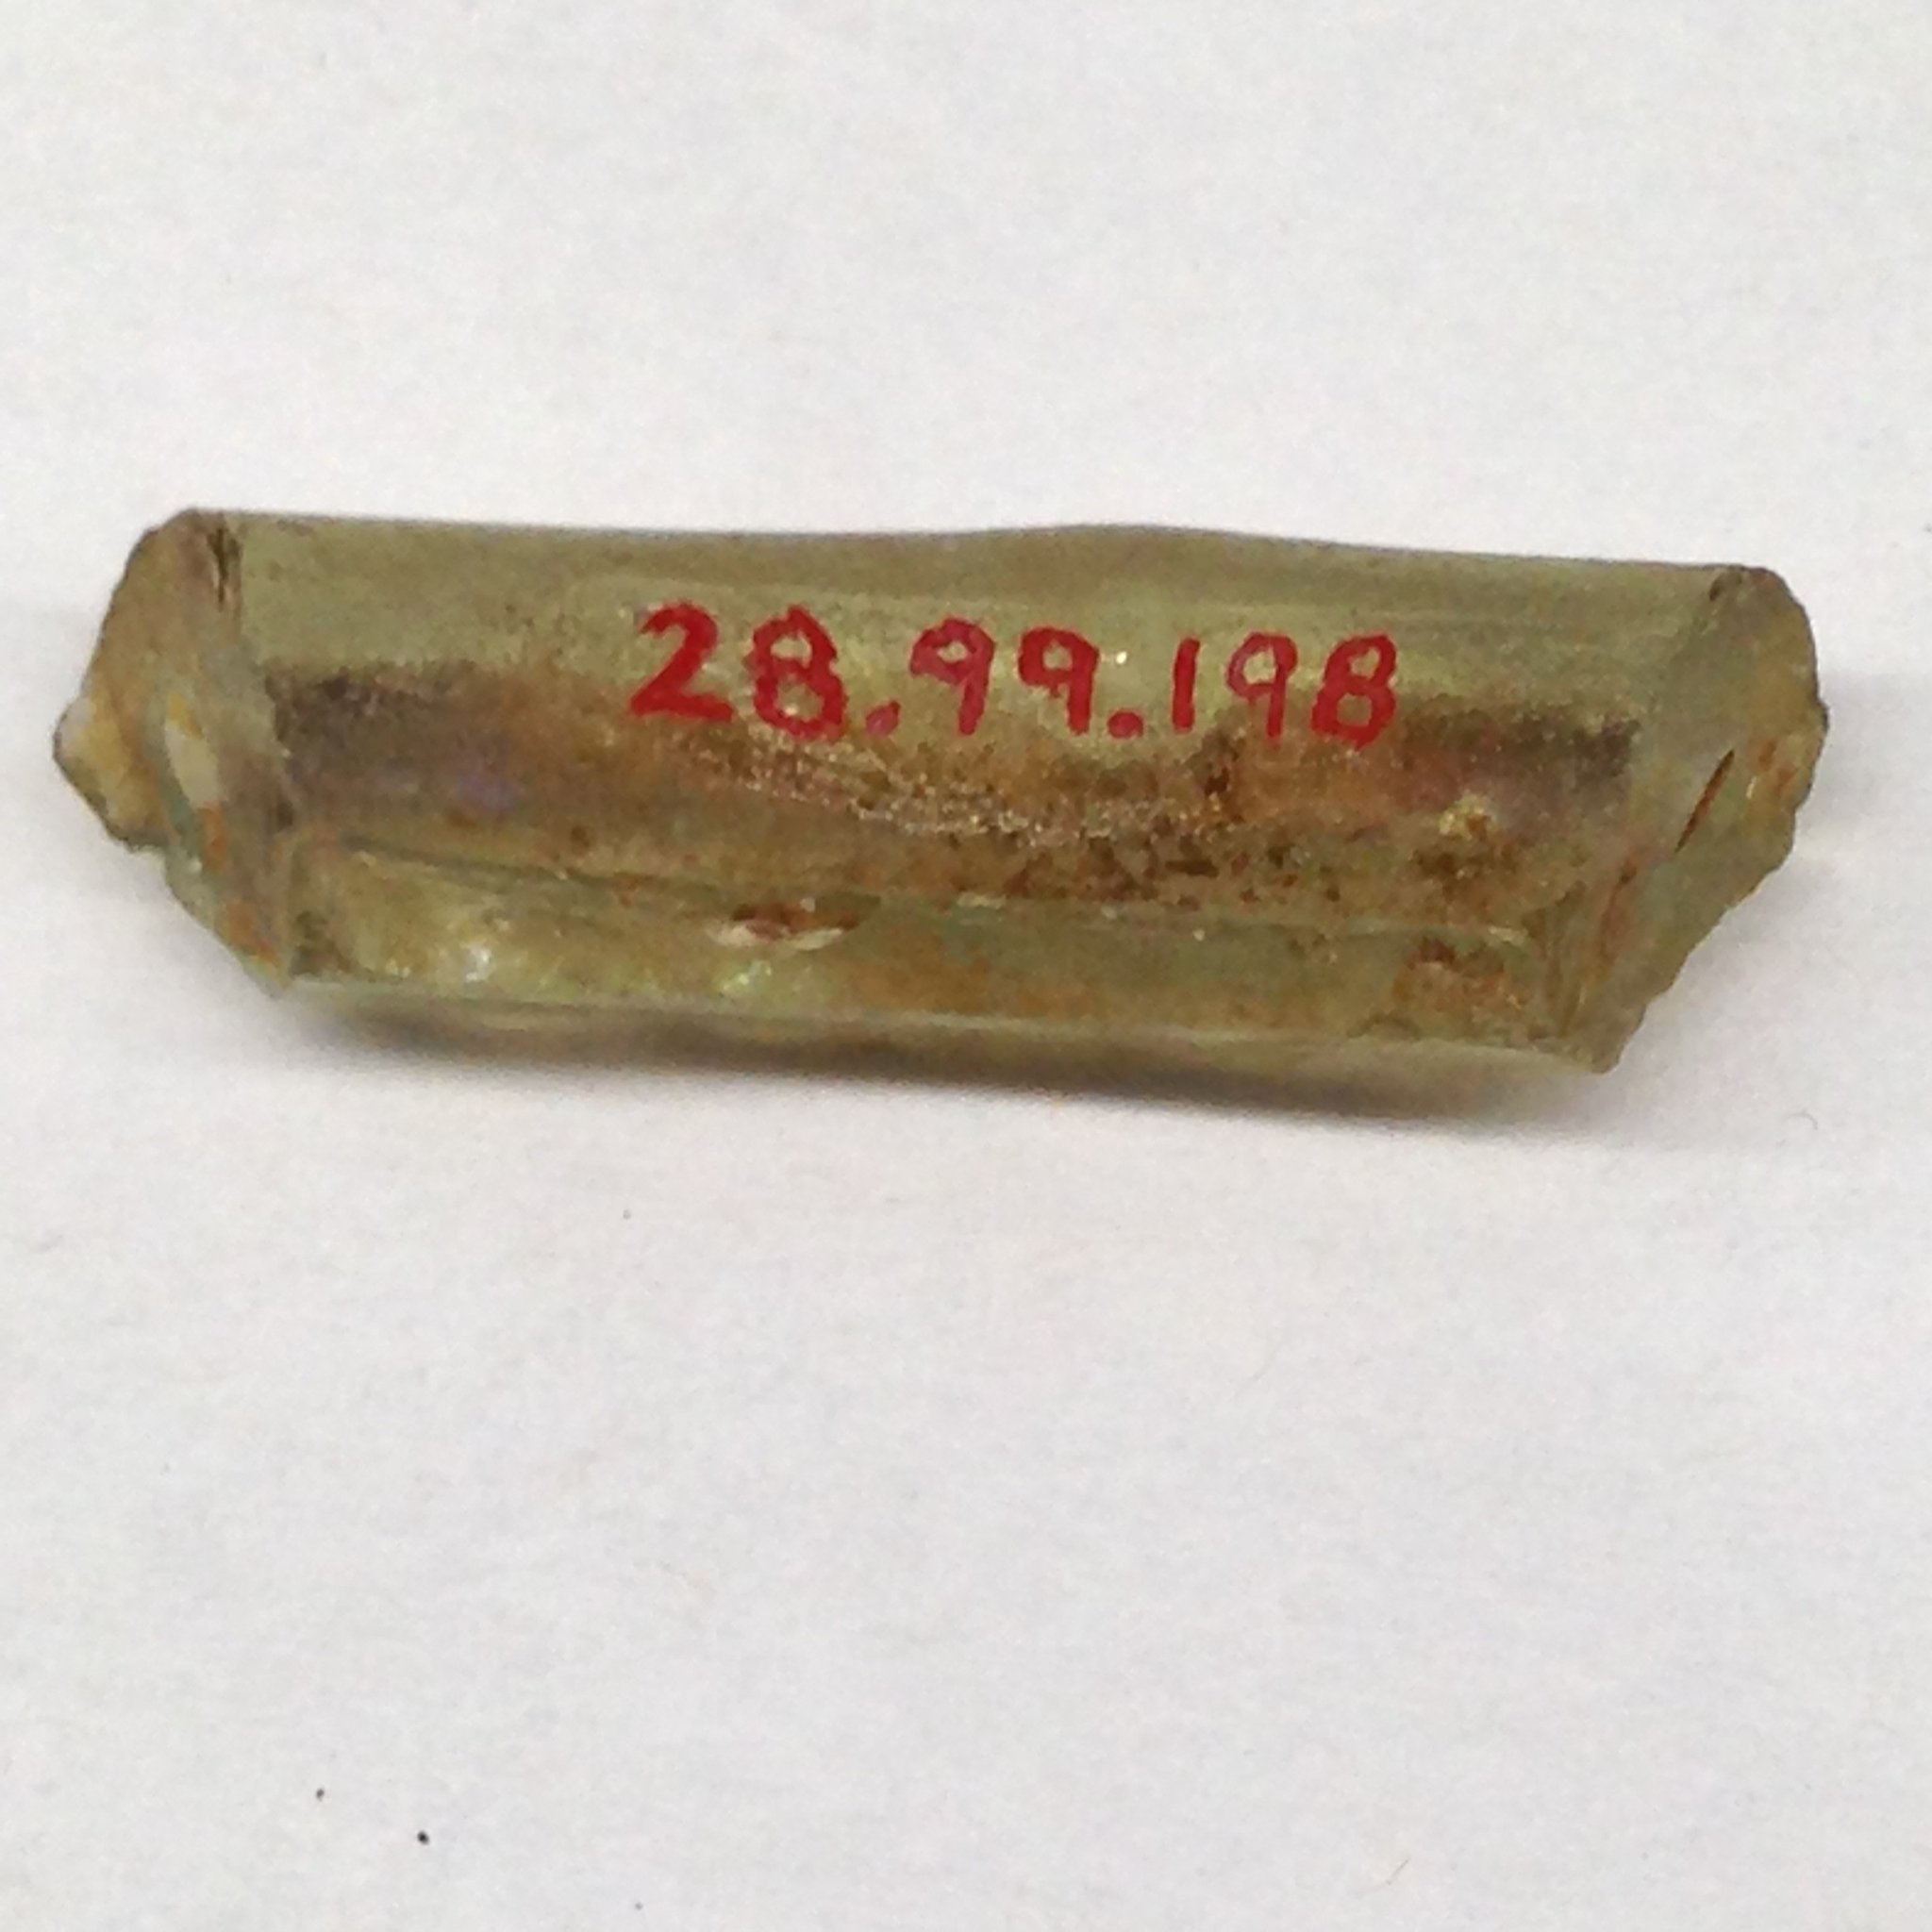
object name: fragment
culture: european or middle eastern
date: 1150-1250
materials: ceramic, glass